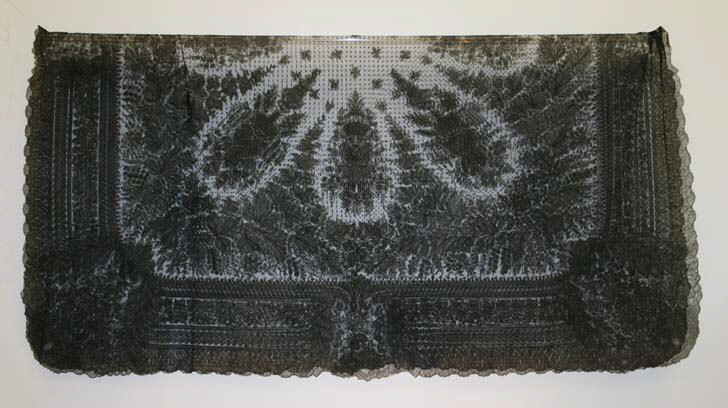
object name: shawl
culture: american or european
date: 1860-1869